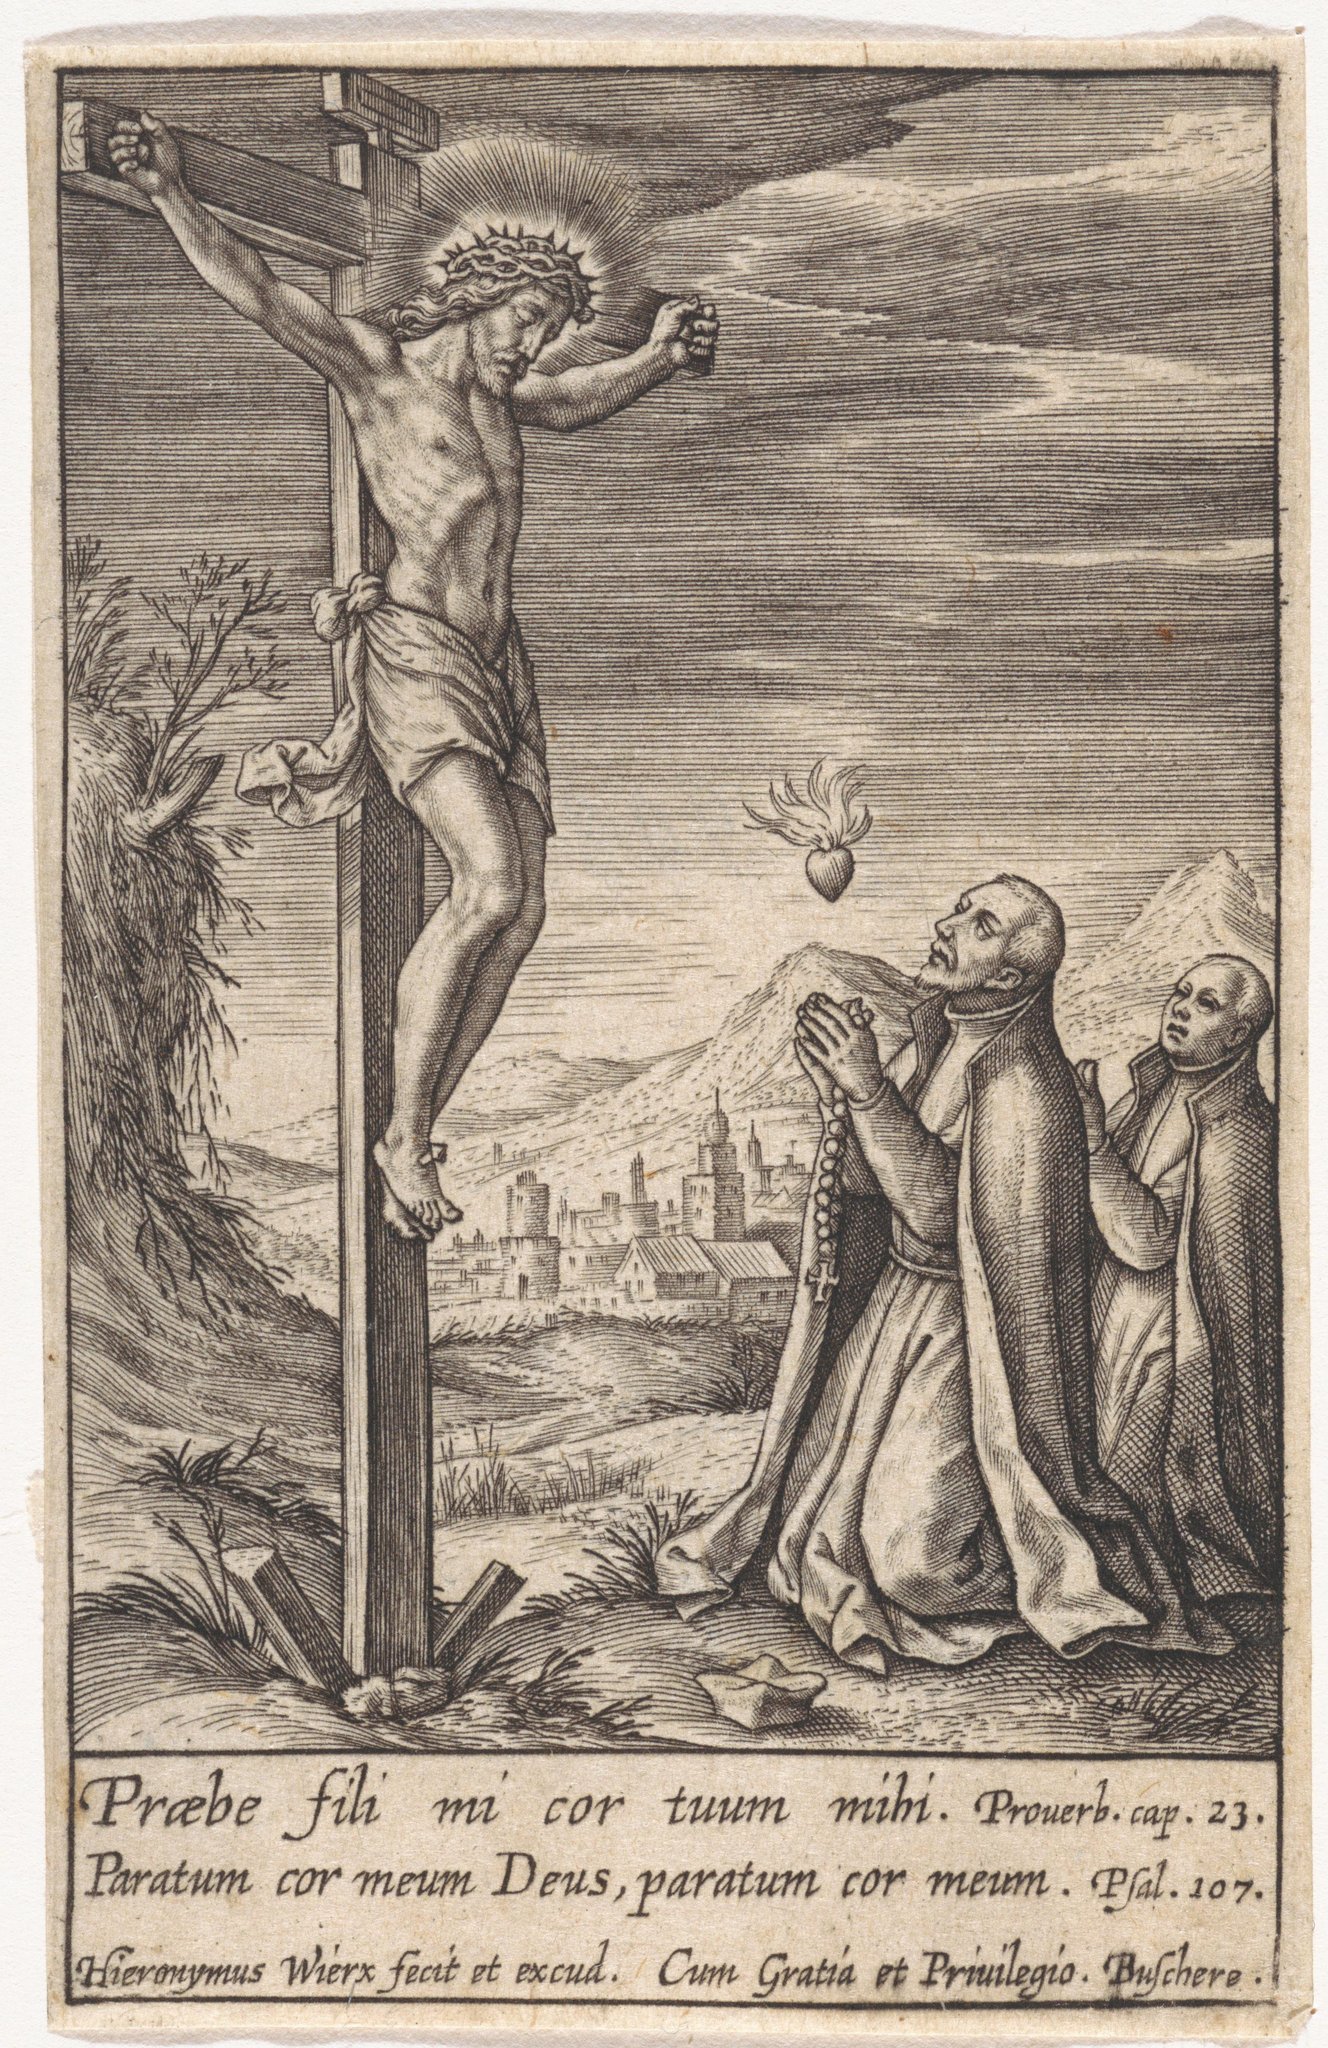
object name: print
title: Gekruisigde Christus aanbeden door Franciscus Xaverius en Stanislaus Kostka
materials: paper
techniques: engraving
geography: antwerp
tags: clergyman, missionary, venerating the cross, the jesuit missionary francis xavier; possible attributes: cross, crucifix, flaming heart, indian, lily, torch, male saints (with name)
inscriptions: collector's mark: Lugt 2228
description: Christus hangt aan het kruis. Aan de voet van het kruis knielen de jezuïeten Franciscus Xaverius en Stanislaus Kostka in aanbidding. Het vlammende hart daalt op hen neer. In de marge twee Bijbelcitaten uit Spr. 23 en Ps. 107 in het Latijn.